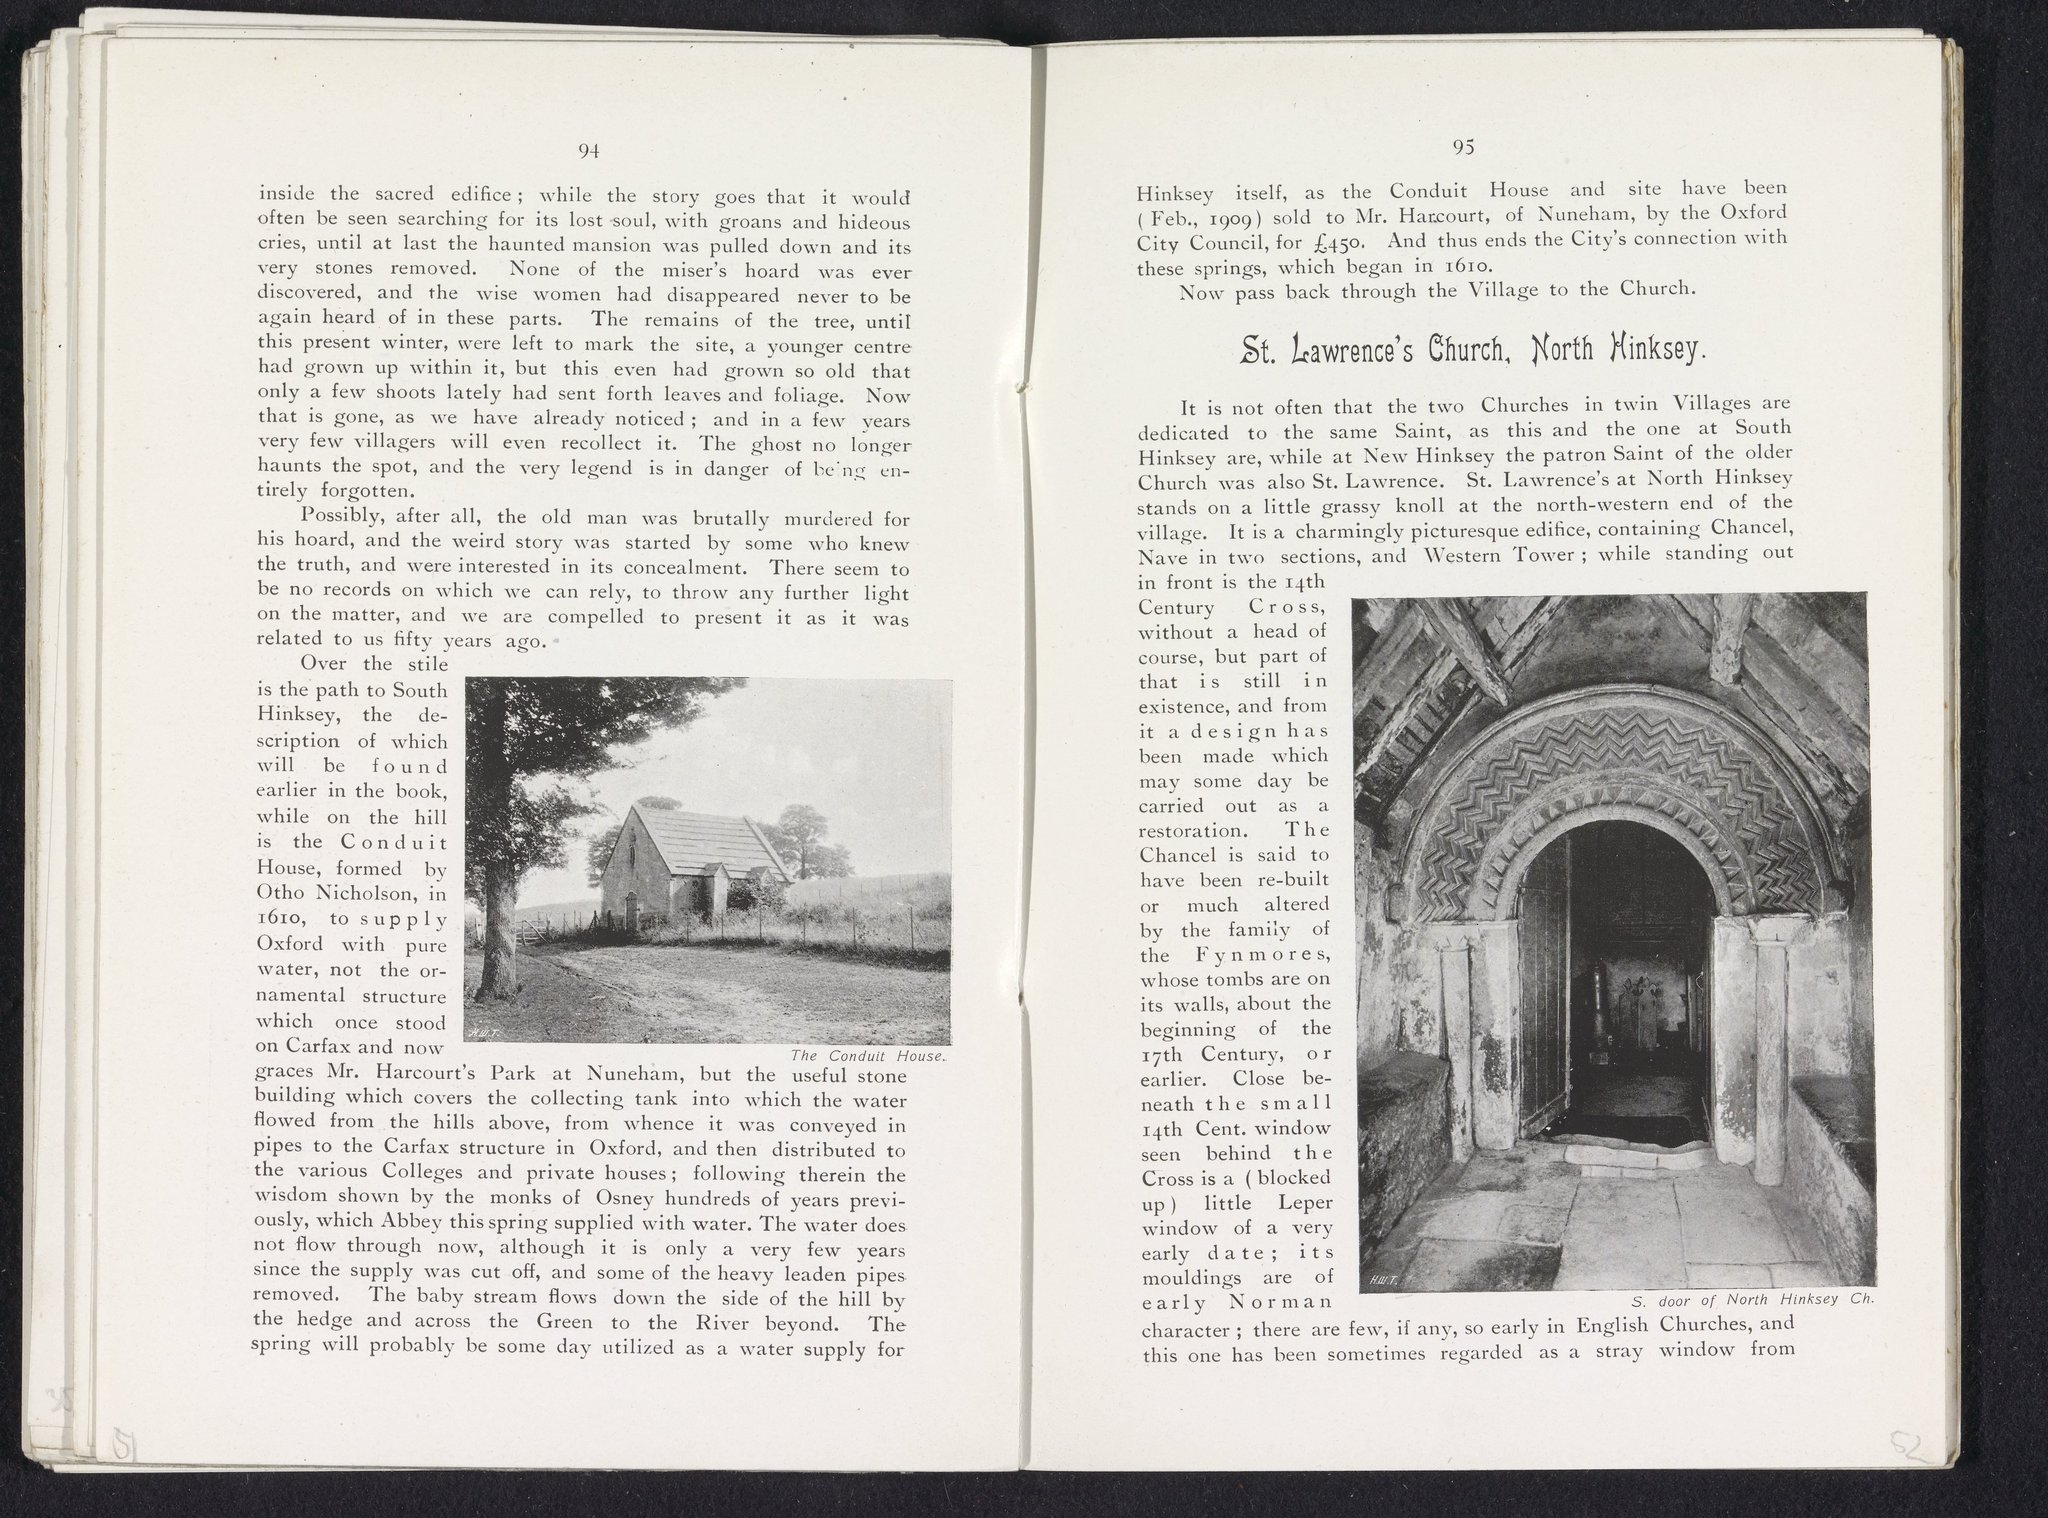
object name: photomechanical print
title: The Conduit House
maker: henry w. taunt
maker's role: fotograaf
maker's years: 1842-1922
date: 1907-1912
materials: paper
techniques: autotype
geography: north hinksey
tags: water-supply (~ public services), façade (of house or building)